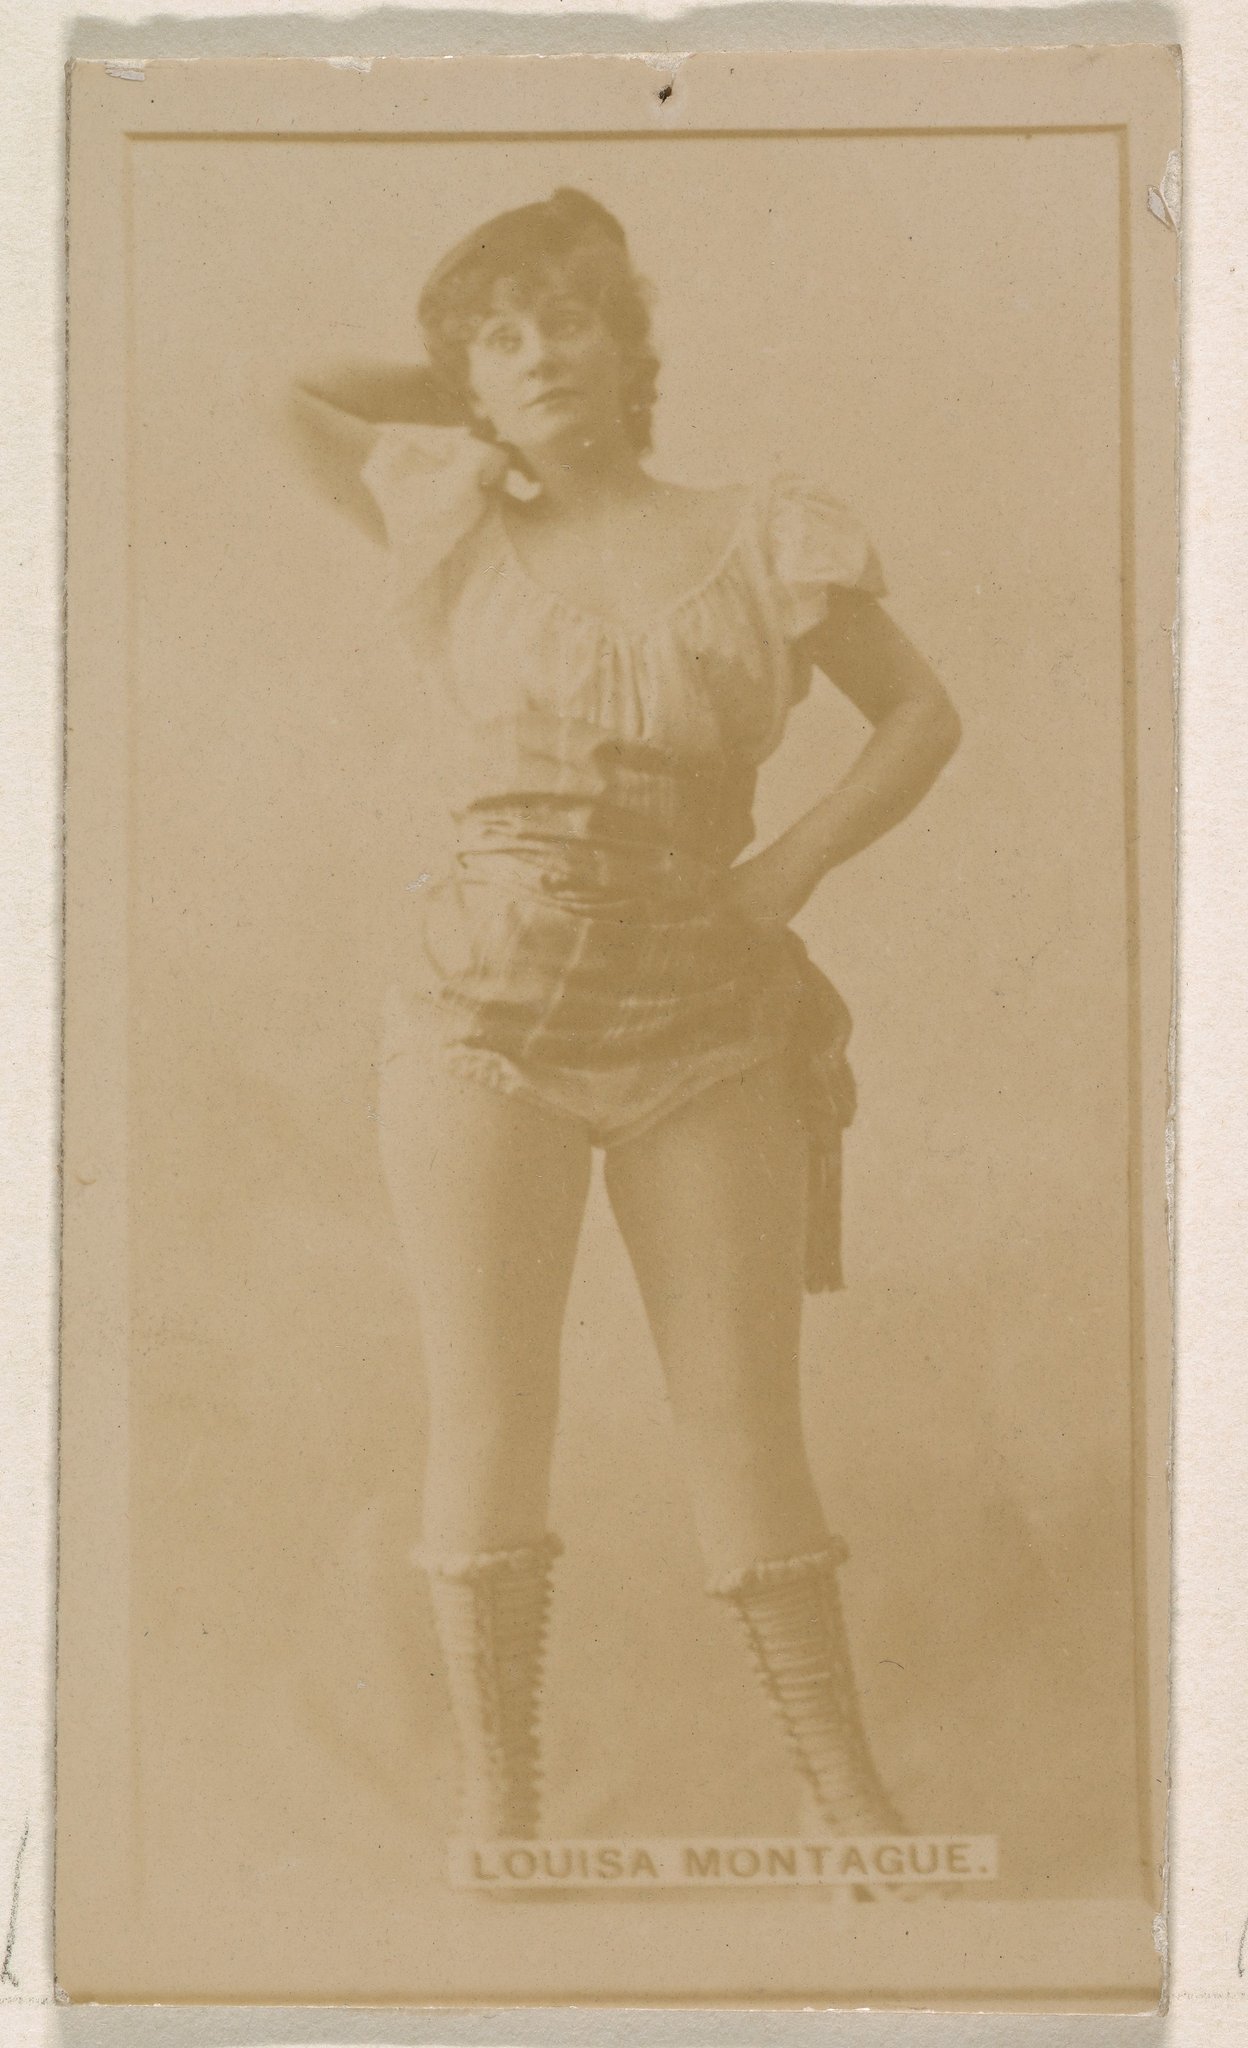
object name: photograph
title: Louise Montague, from the Actresses series (N245) issued by Kinney Brothers to promote Sweet Caporal Cigarettes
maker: kinney brothers tobacco company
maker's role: publisher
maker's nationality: american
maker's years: 1869-2011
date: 1890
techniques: albumen silver print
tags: portraits,women,actresses